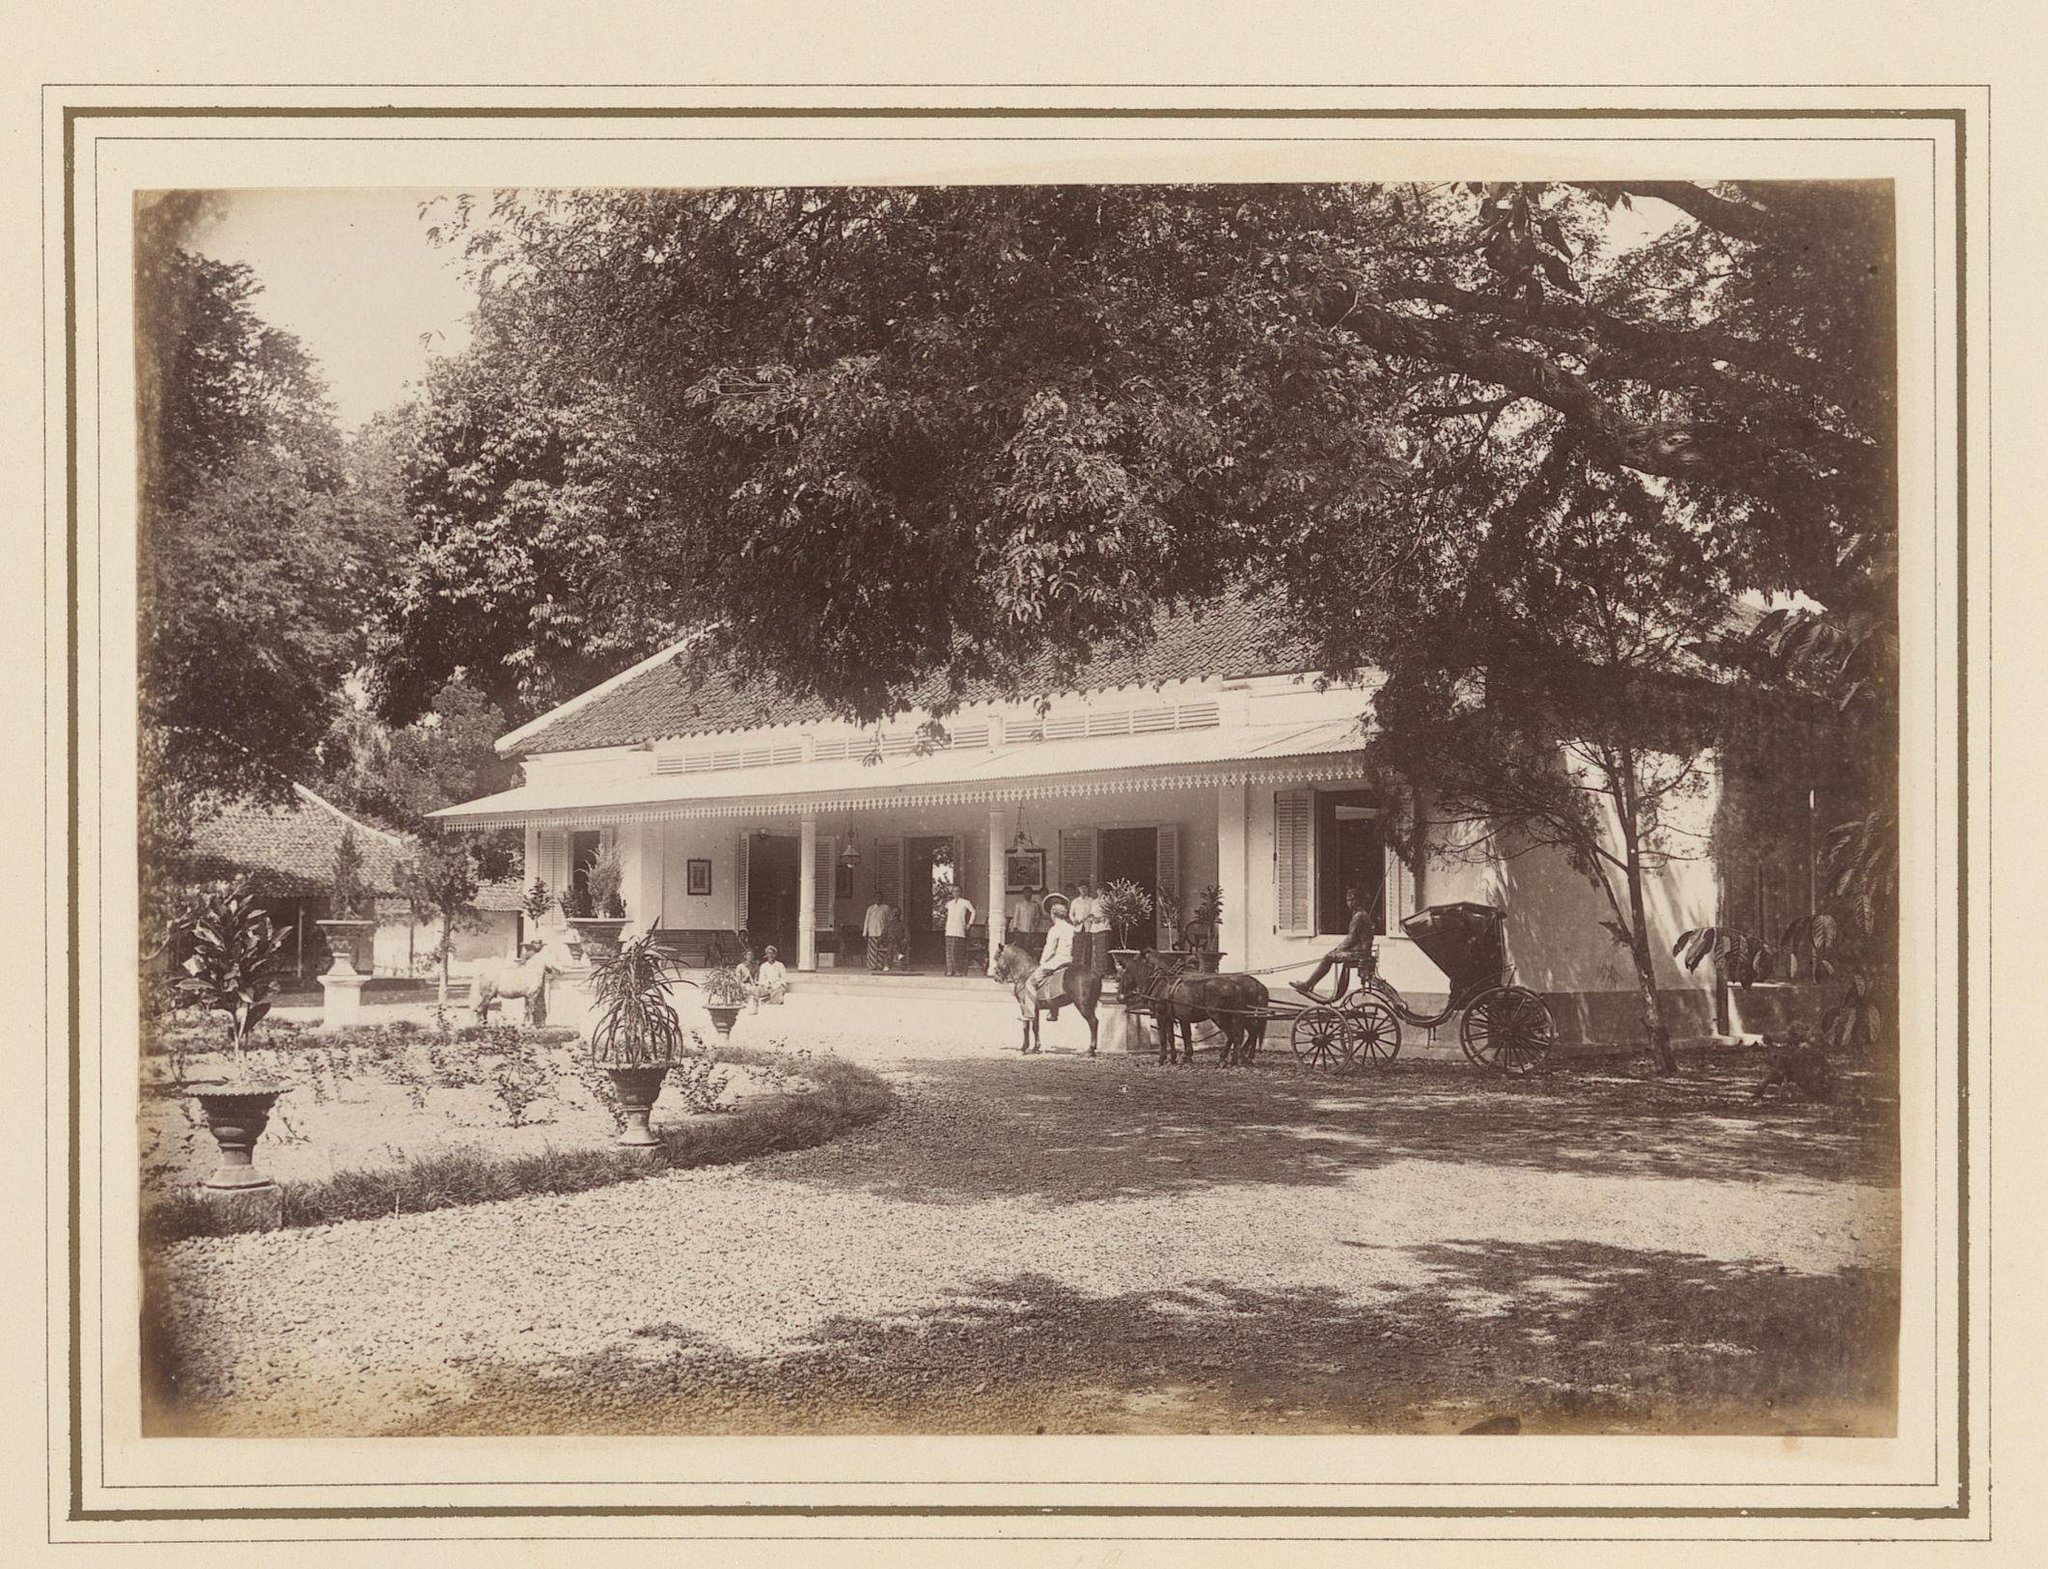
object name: photograph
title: Woonhuis met personeel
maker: kassian céphas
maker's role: fotograaf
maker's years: 1845-1912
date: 1886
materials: photographic support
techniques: albumen print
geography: jogjakarta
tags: the hague, colonial system, villa, house personnel, servants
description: Gezicht op een woonhuis, met het personeel op de veranda, rechts een koets. Onderdeel van het fotoalbum aangeboden aan J.M. Pijnacker Hordijk bij zijn vertrek uit Jogyakarta in 1886.